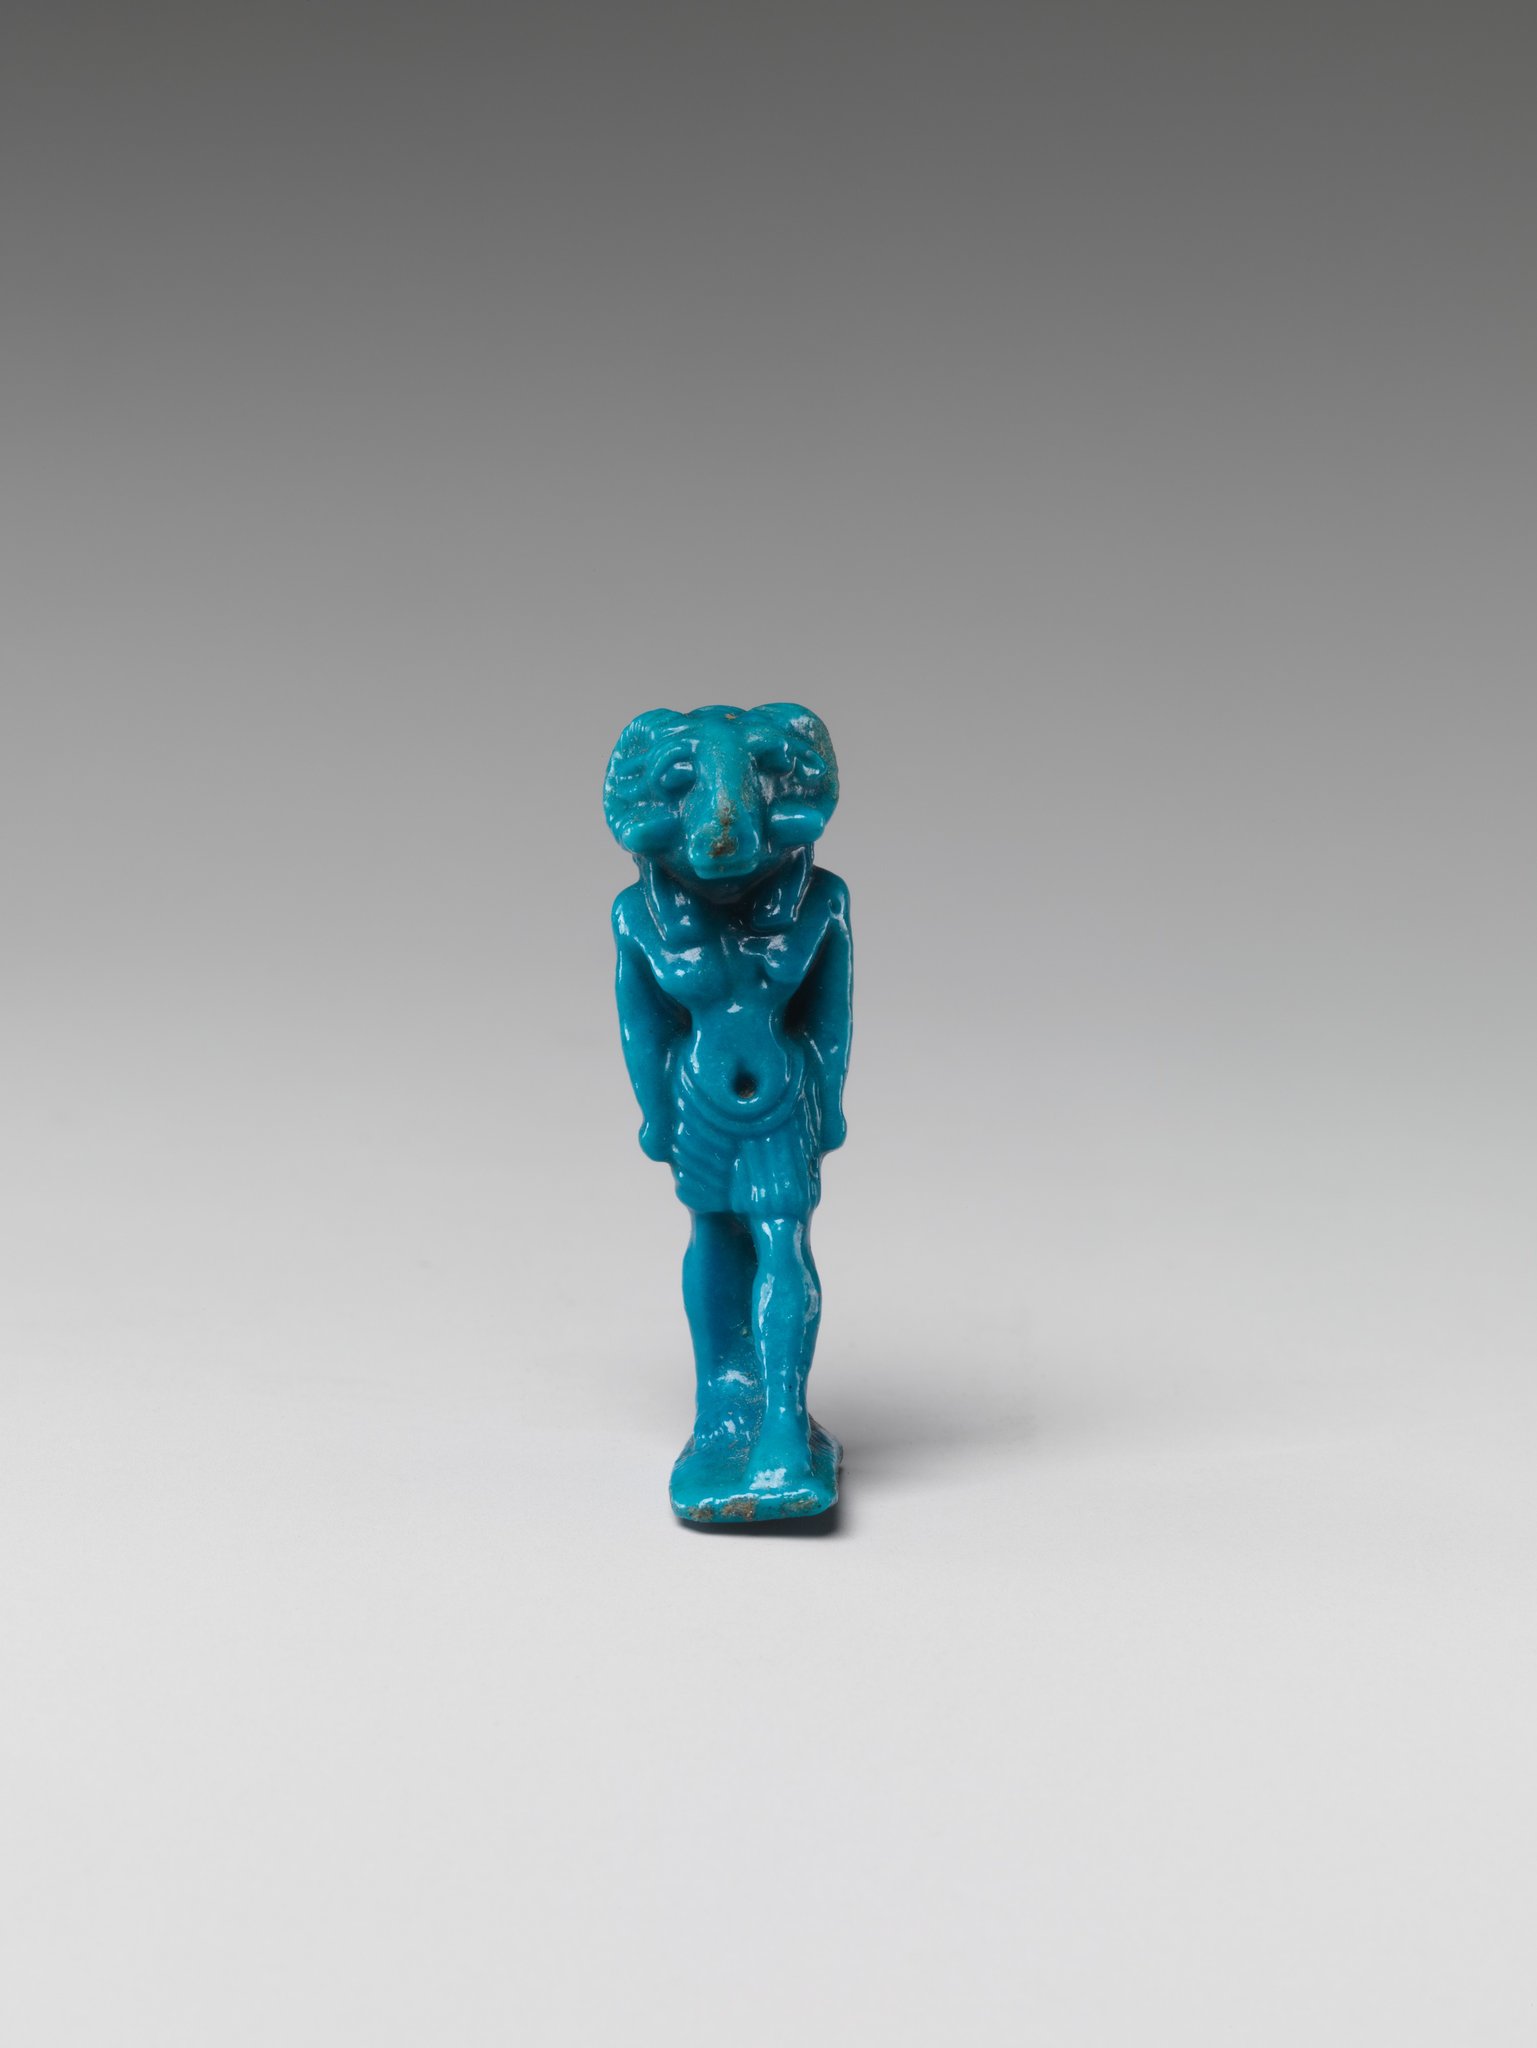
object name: amulet, khnum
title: Amulet of Khnum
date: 332-330 BCE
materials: faience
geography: egypt